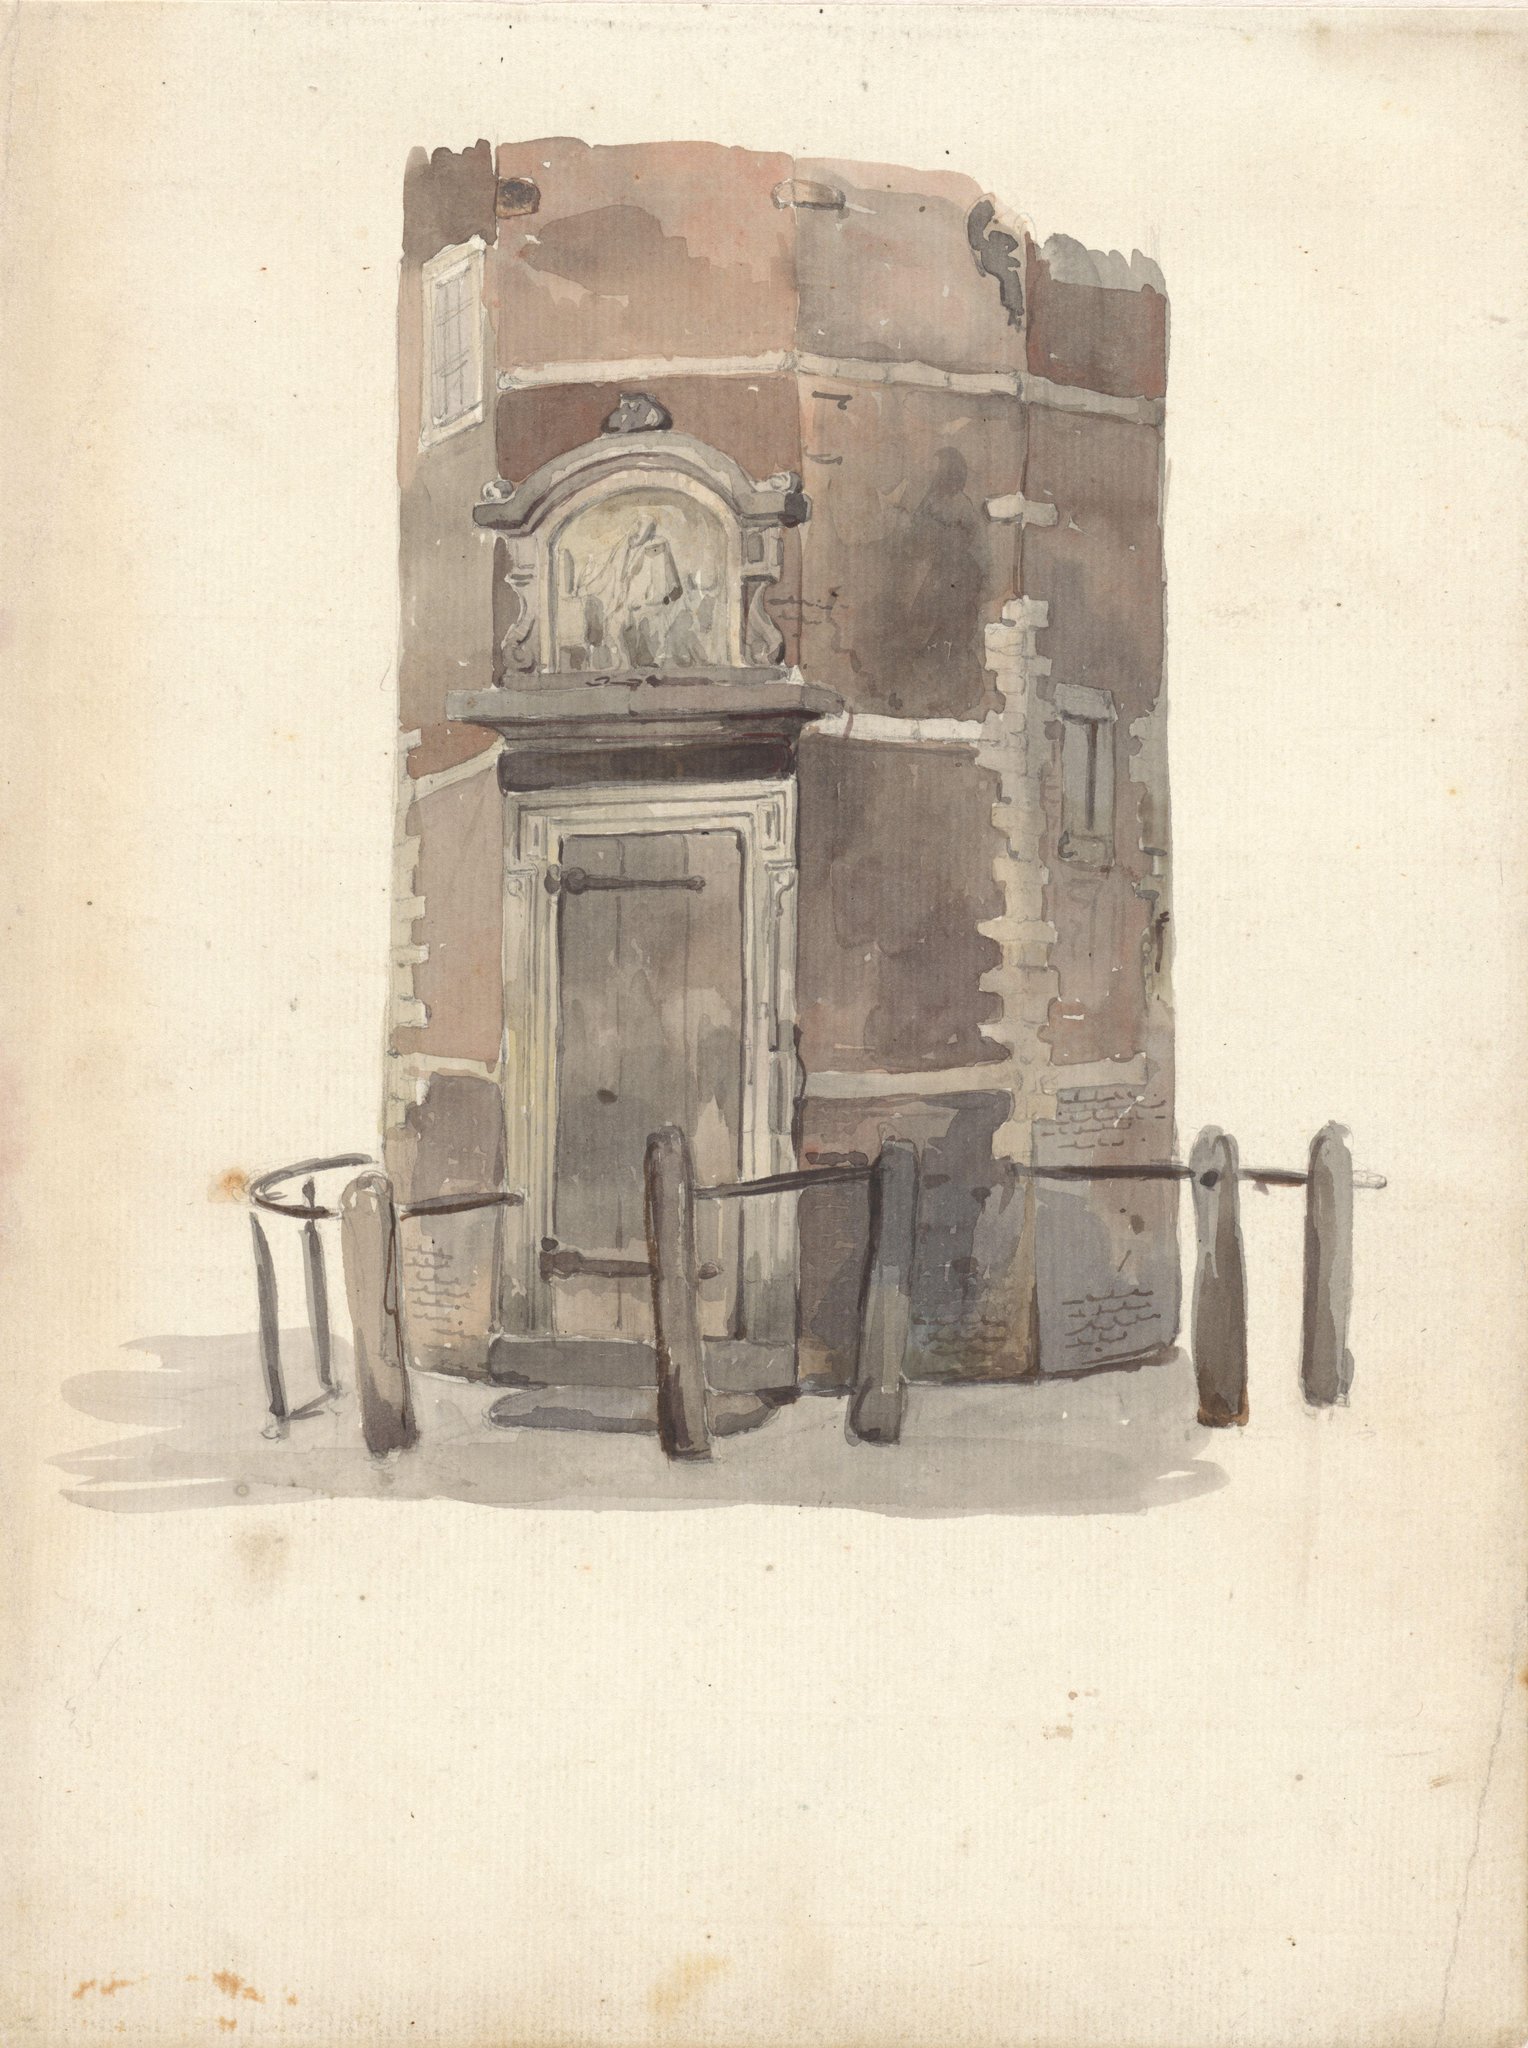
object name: drawing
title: Poortje van het gilde in de St. Anthoniswaag, Amsterdam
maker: johan adolph rust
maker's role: draughtsman, painter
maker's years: 1828-1915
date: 1838-1915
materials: paper, pencil, watercolor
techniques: brush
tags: door, amsterdam